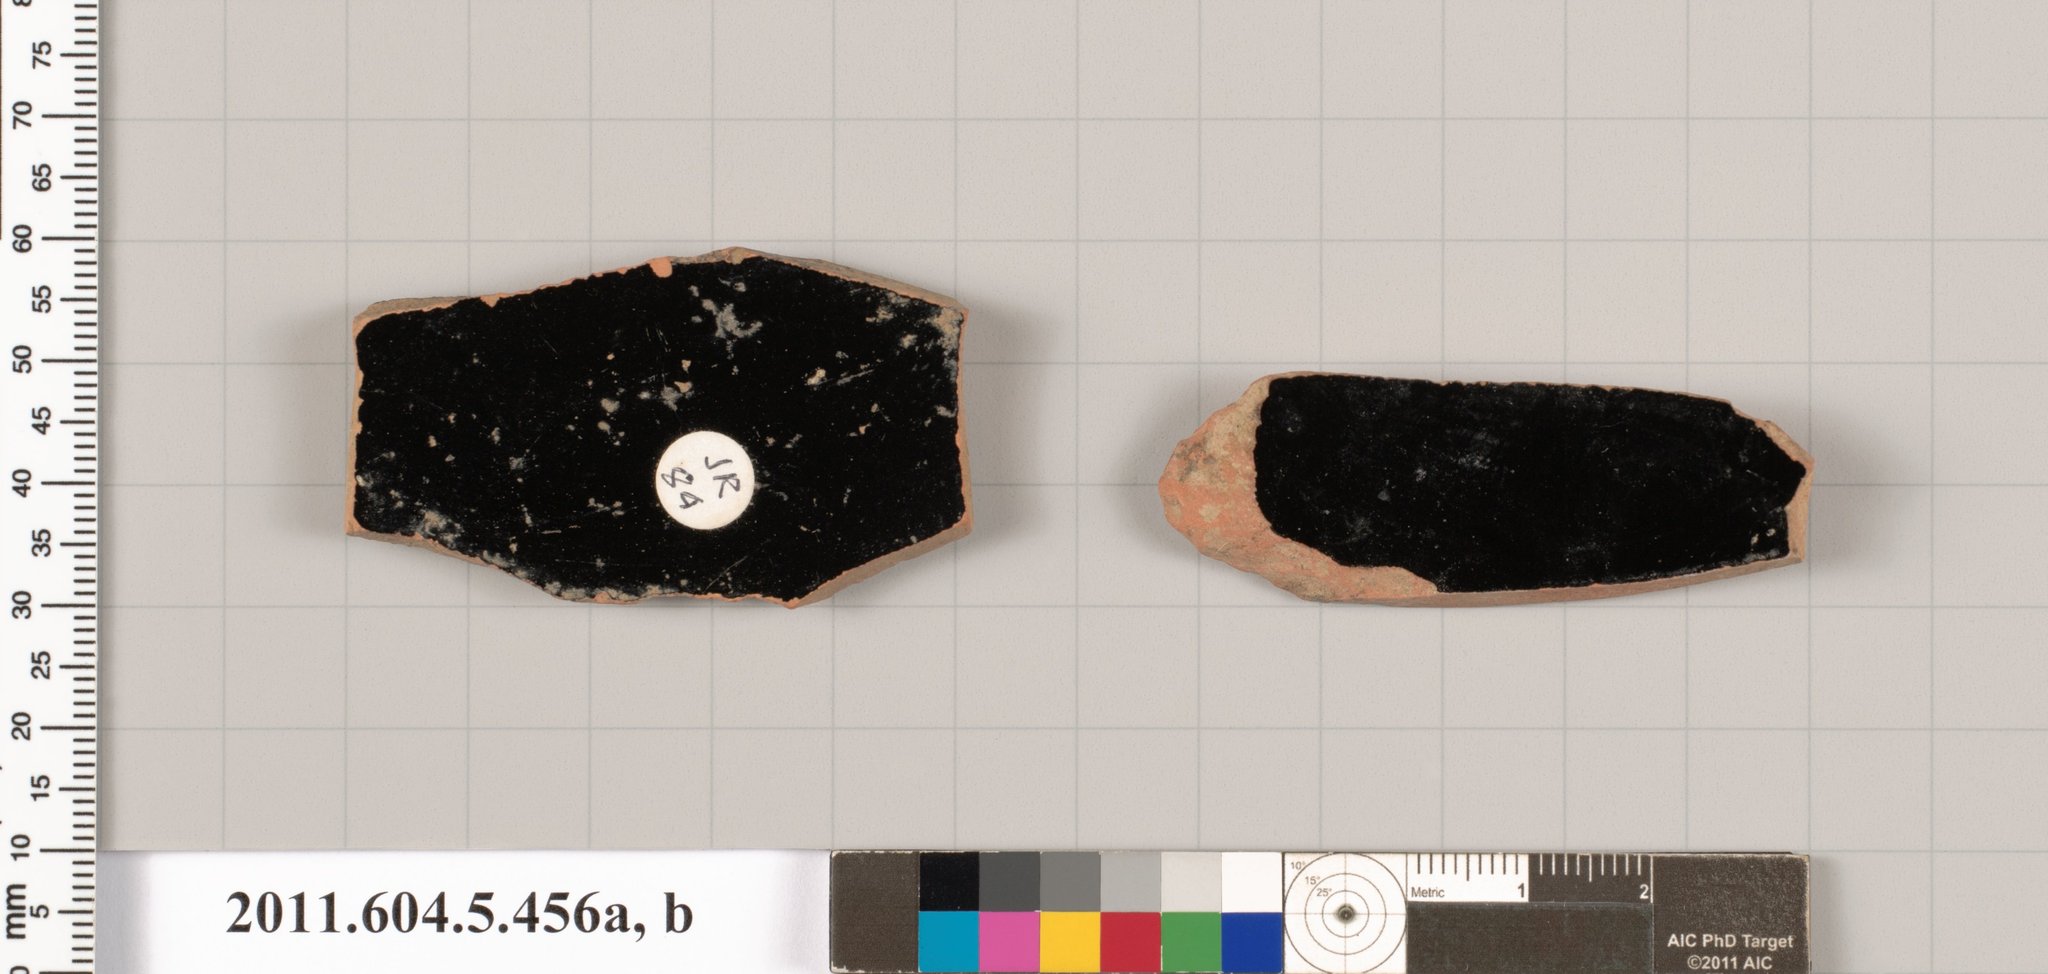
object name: kylix fragment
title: Terracotta fragments of kylikes (drinking cups)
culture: greek, attic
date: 600-401 BCE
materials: terracotta